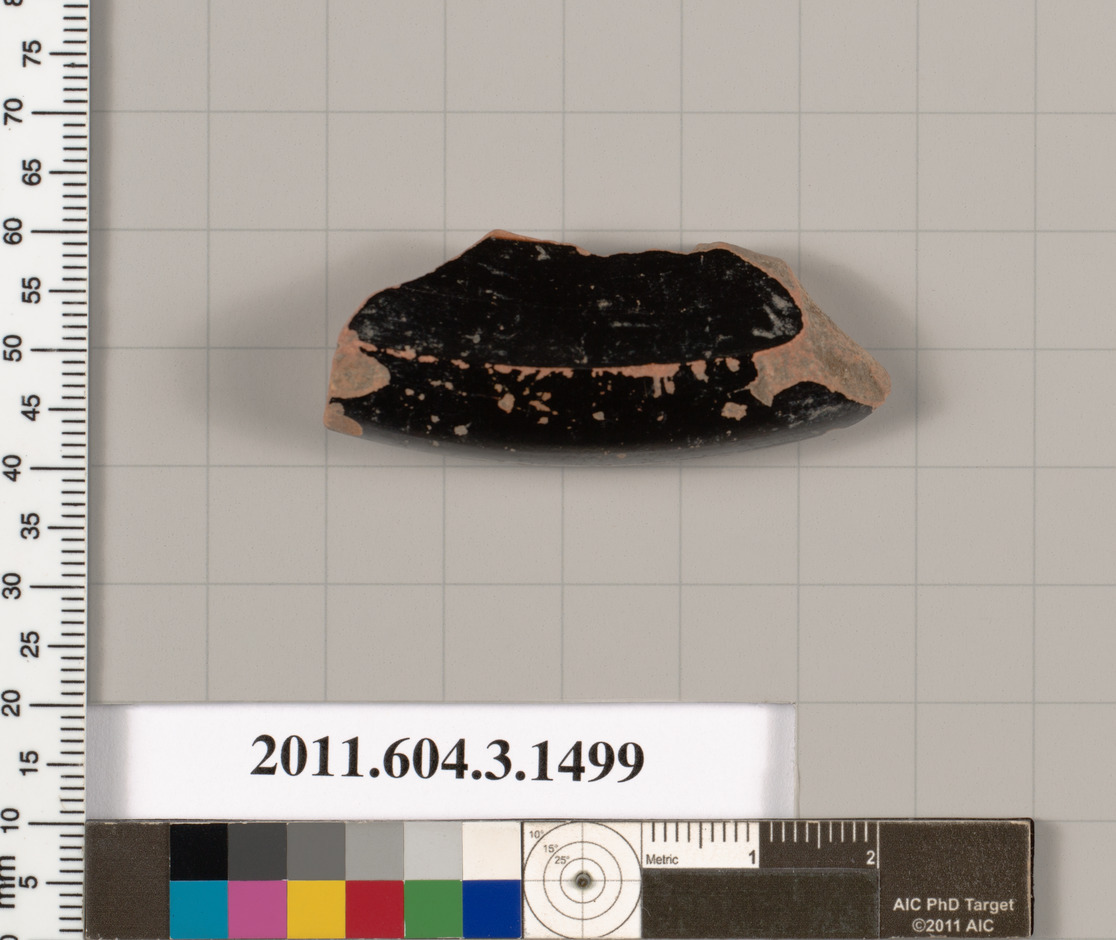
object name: skyphos fragment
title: Terracotta fragment of a skyphos (deep drinking cup)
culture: greek, attic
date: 600-401 BCE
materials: terracotta